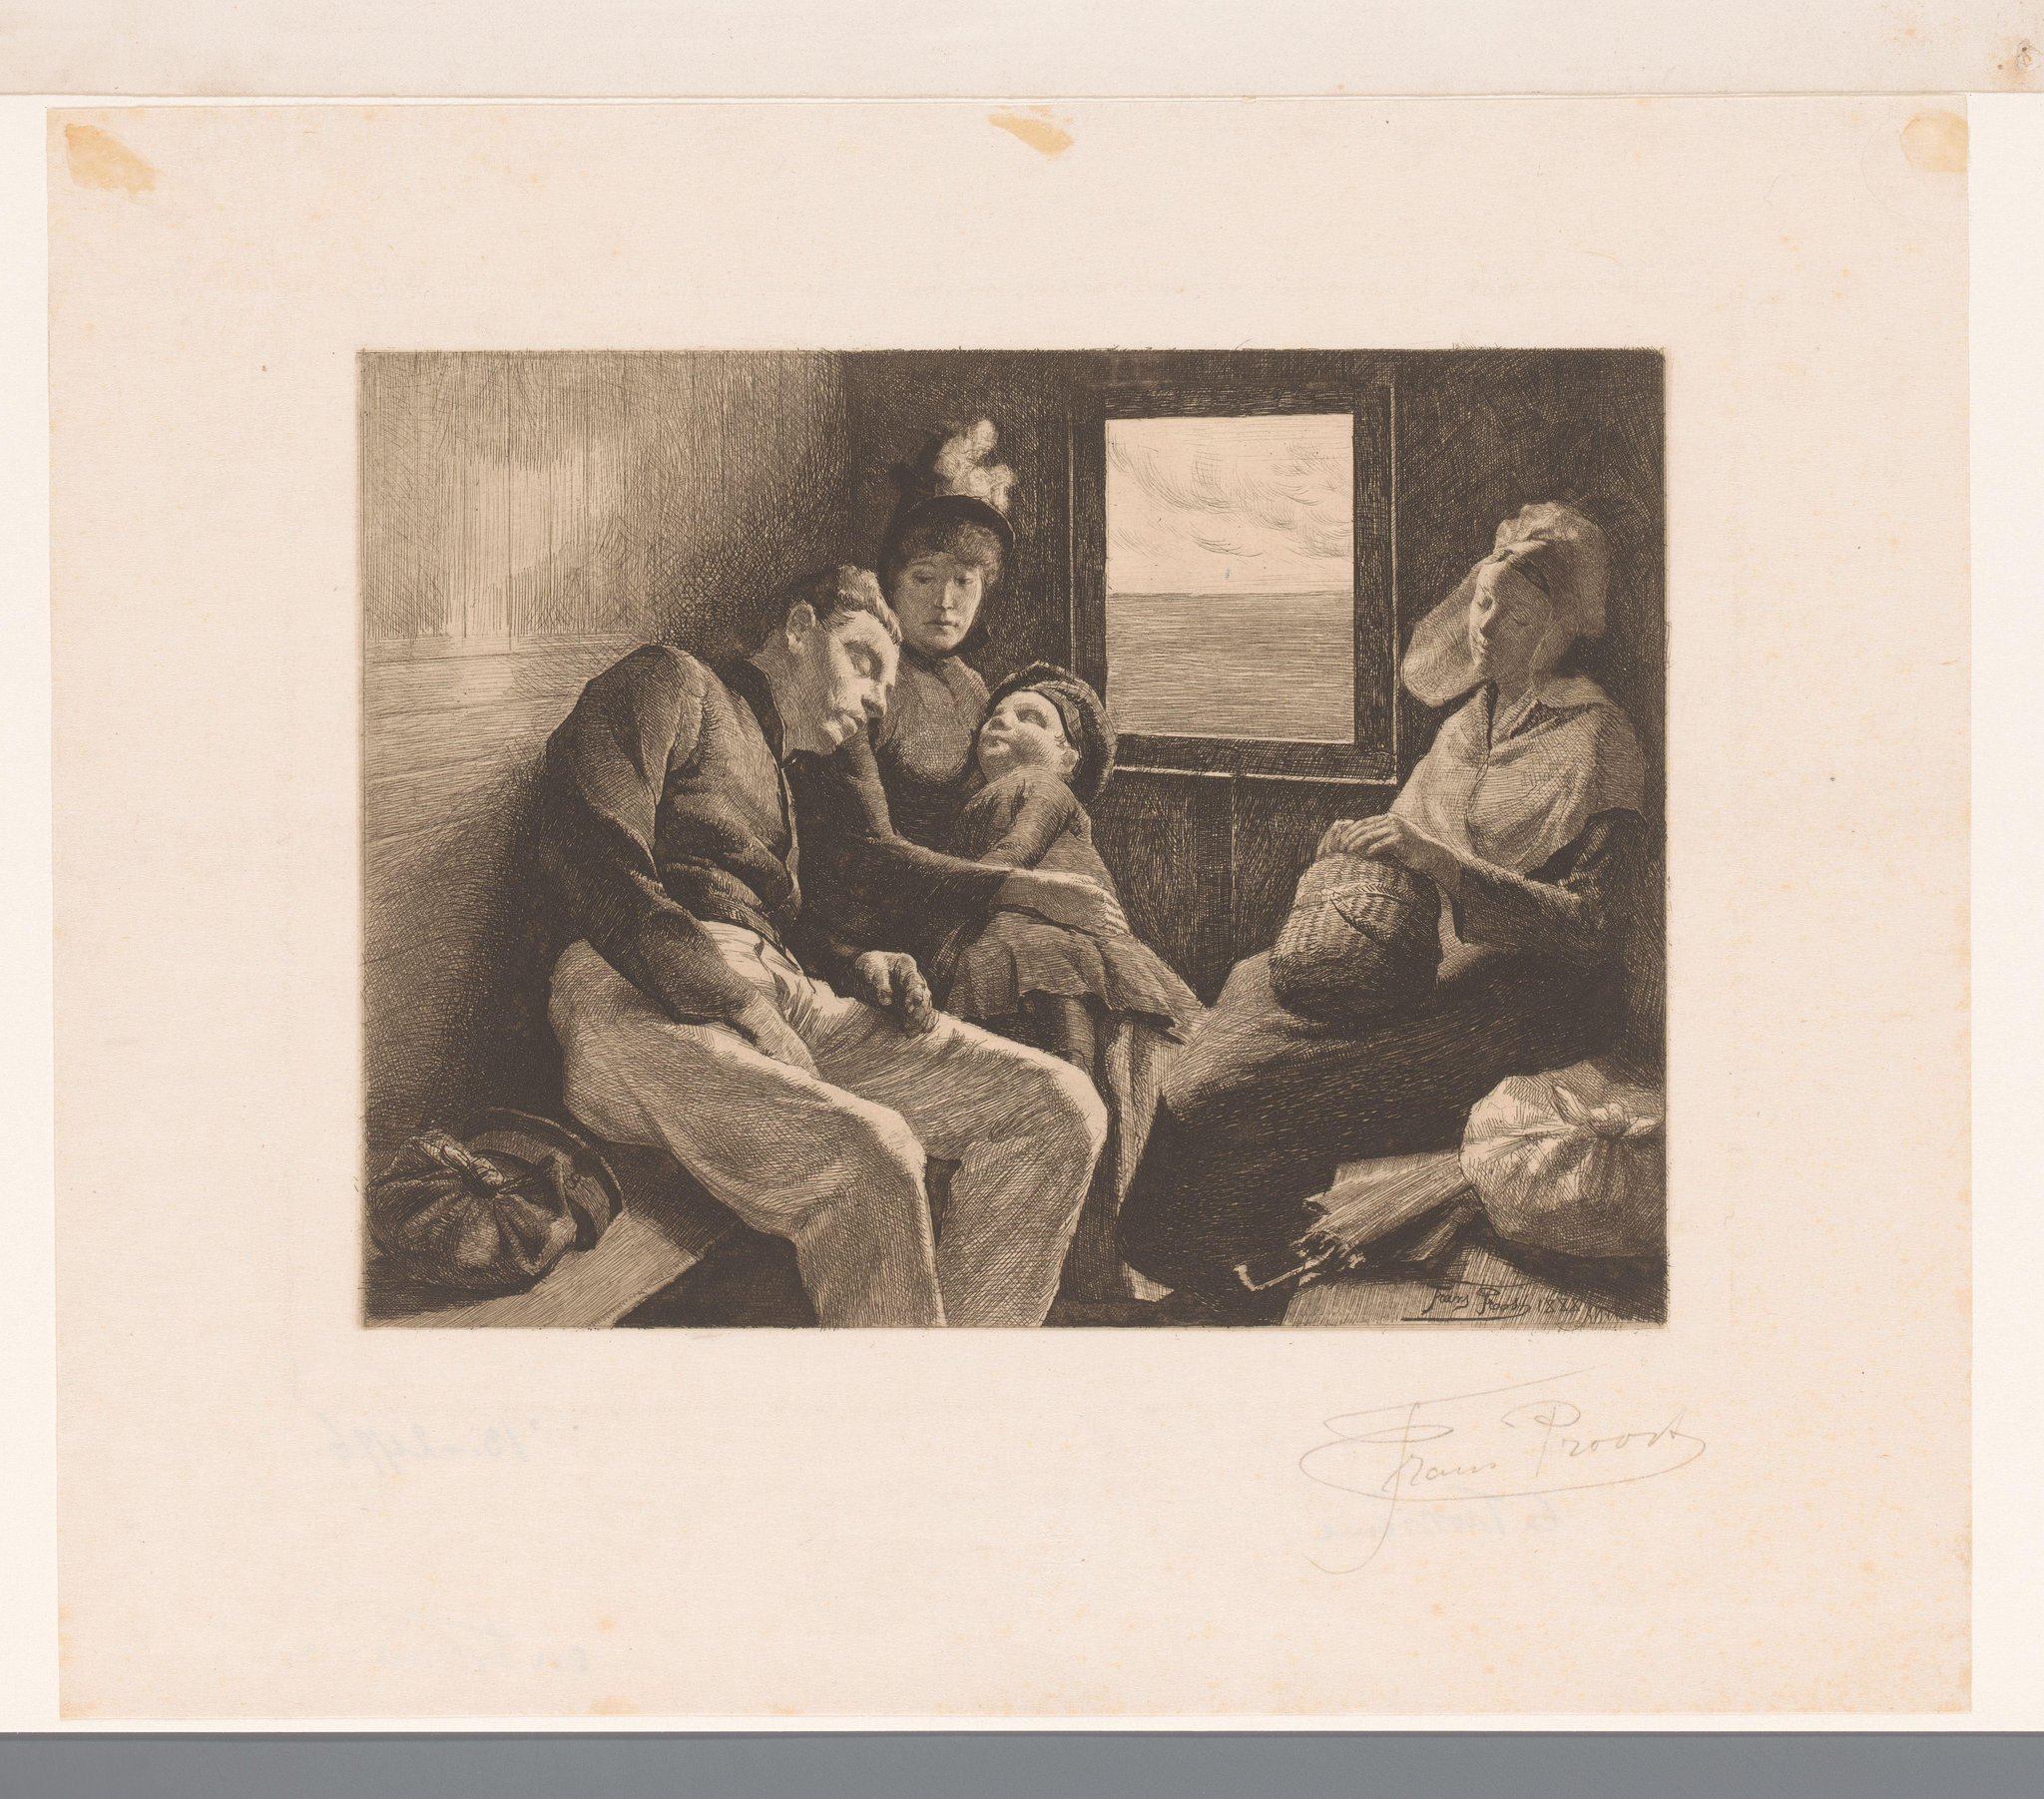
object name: print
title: Vier personen in een derdeklascoupé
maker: frans proost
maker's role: painter, print maker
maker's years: 1875-1941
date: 1888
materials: paper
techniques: drypoint, etching, intaglio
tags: the family travelling, on holiday, passenger train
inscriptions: annotation: ‘En troisième’, collector's mark: Lugt 2228